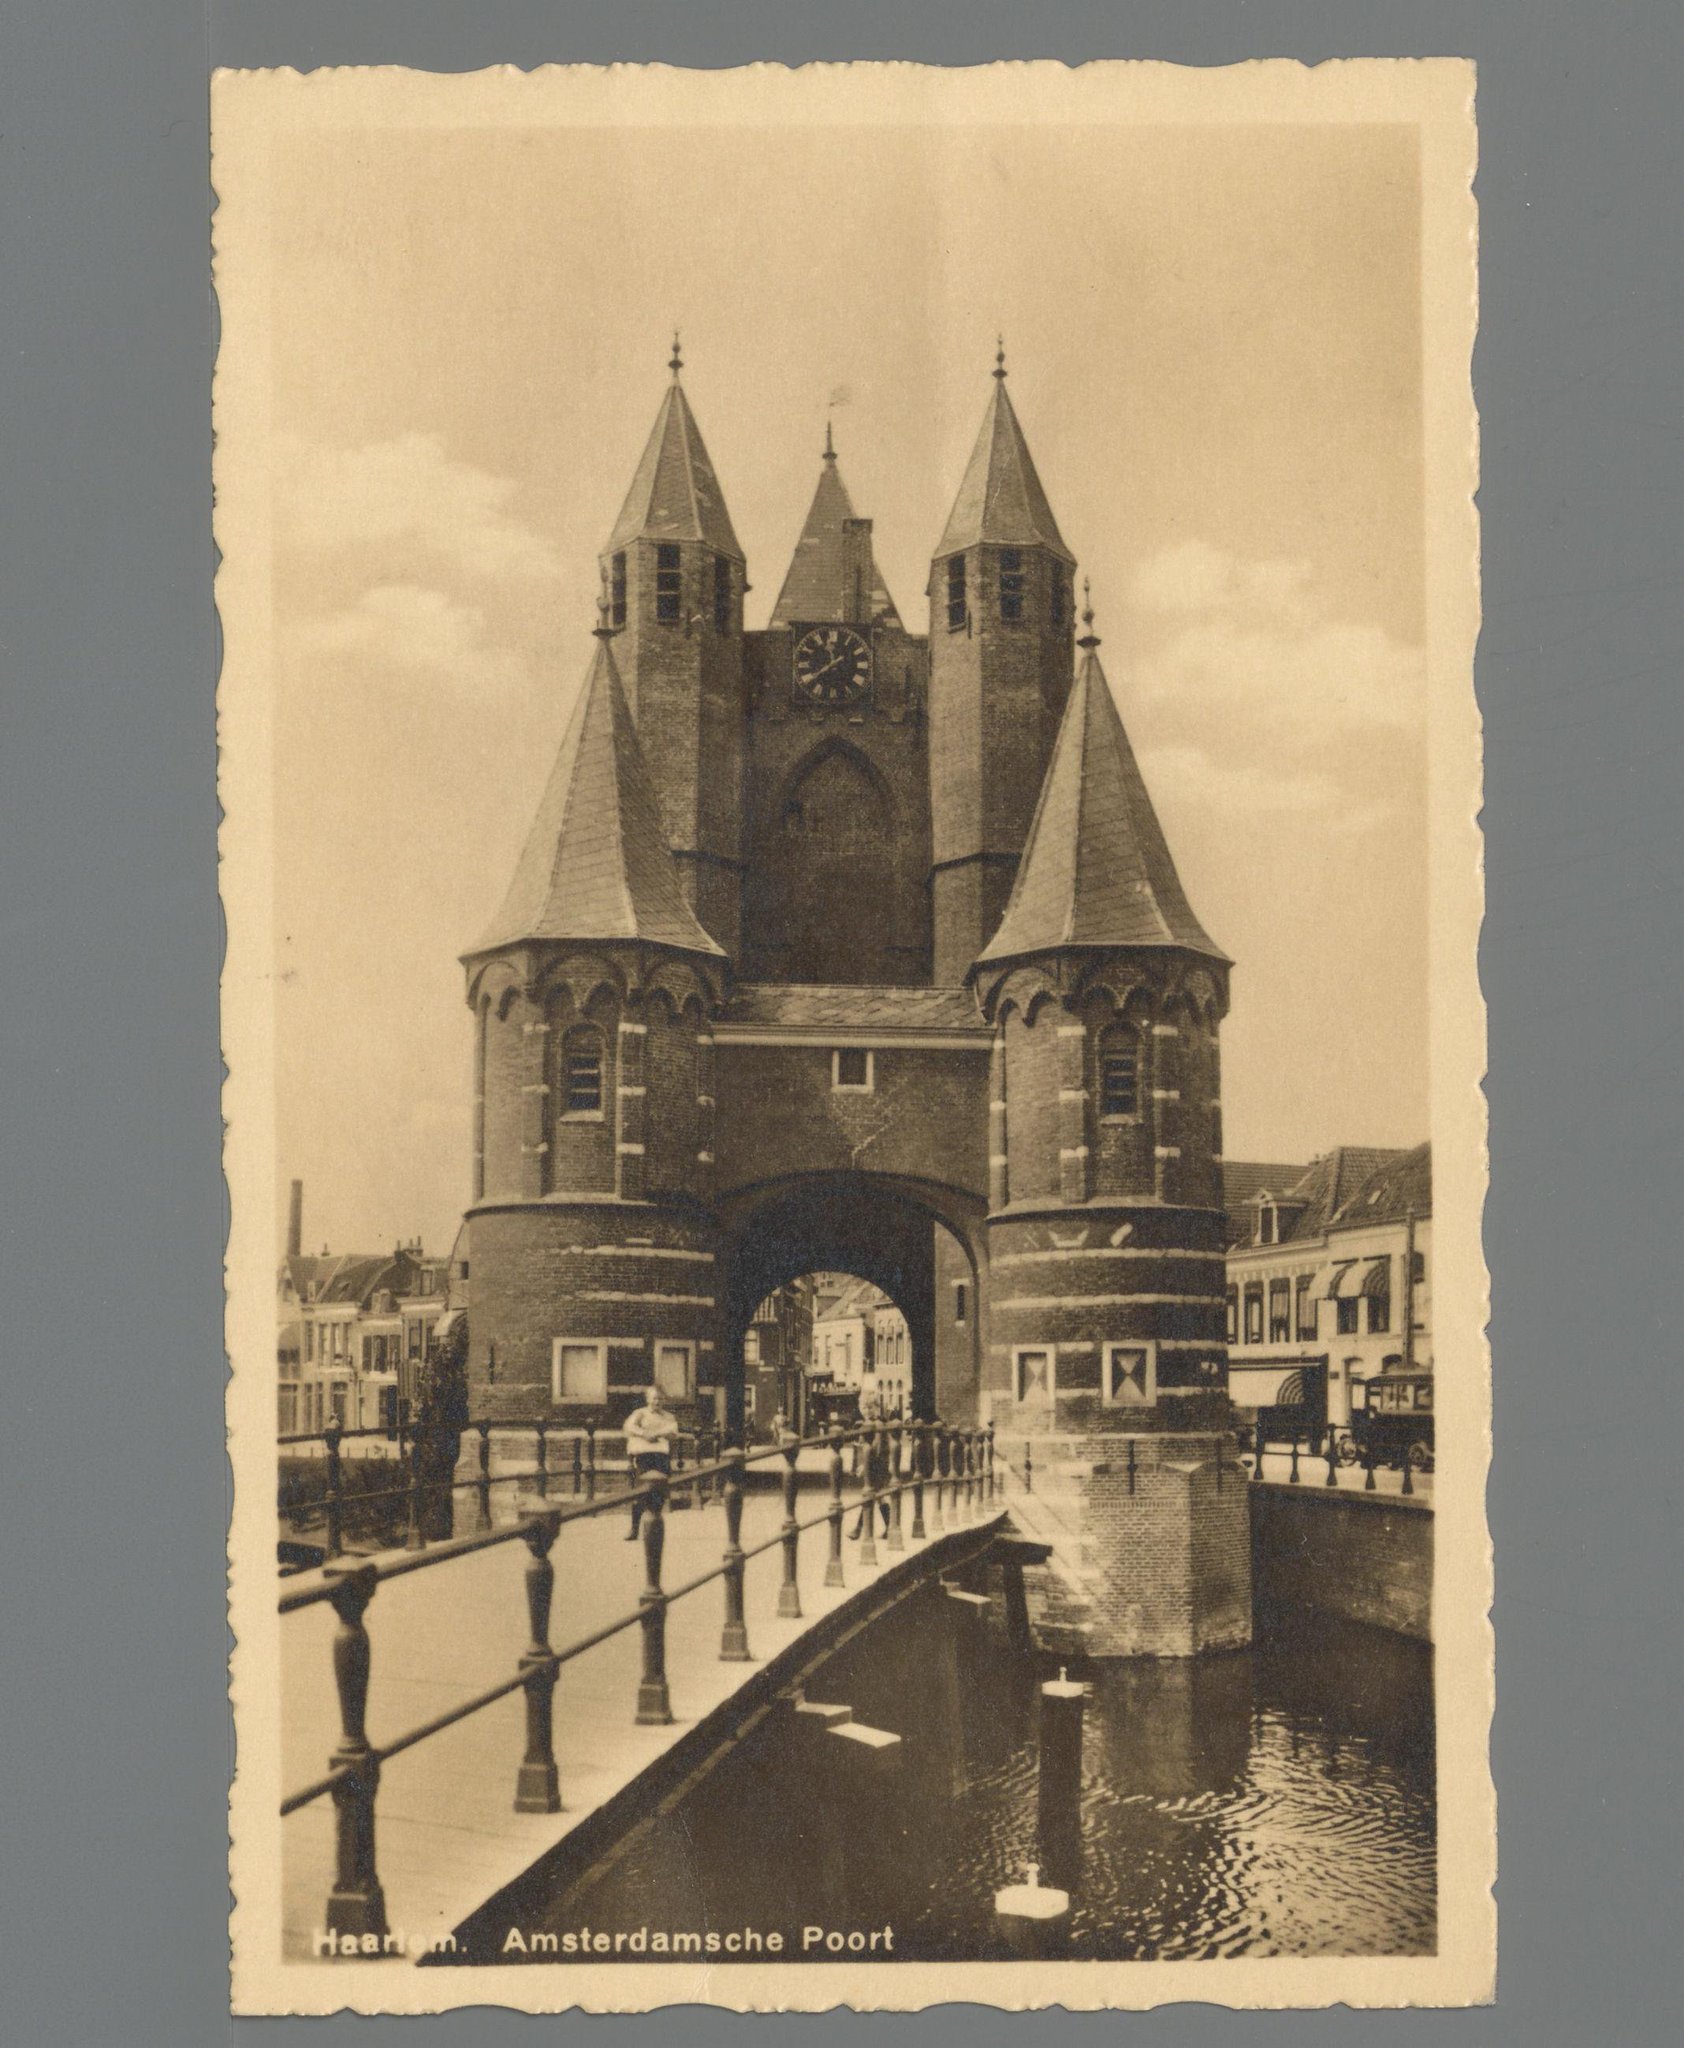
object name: photograph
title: Haarlem. Amsterdamsche Poort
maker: Anonymous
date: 1927-1935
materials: photographic support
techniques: gelatin silver print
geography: haarlem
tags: city-view, and landscape with man-made constructions, canals, waters (in city), bridge in city across river, canal, etc., city-gate, haarlem